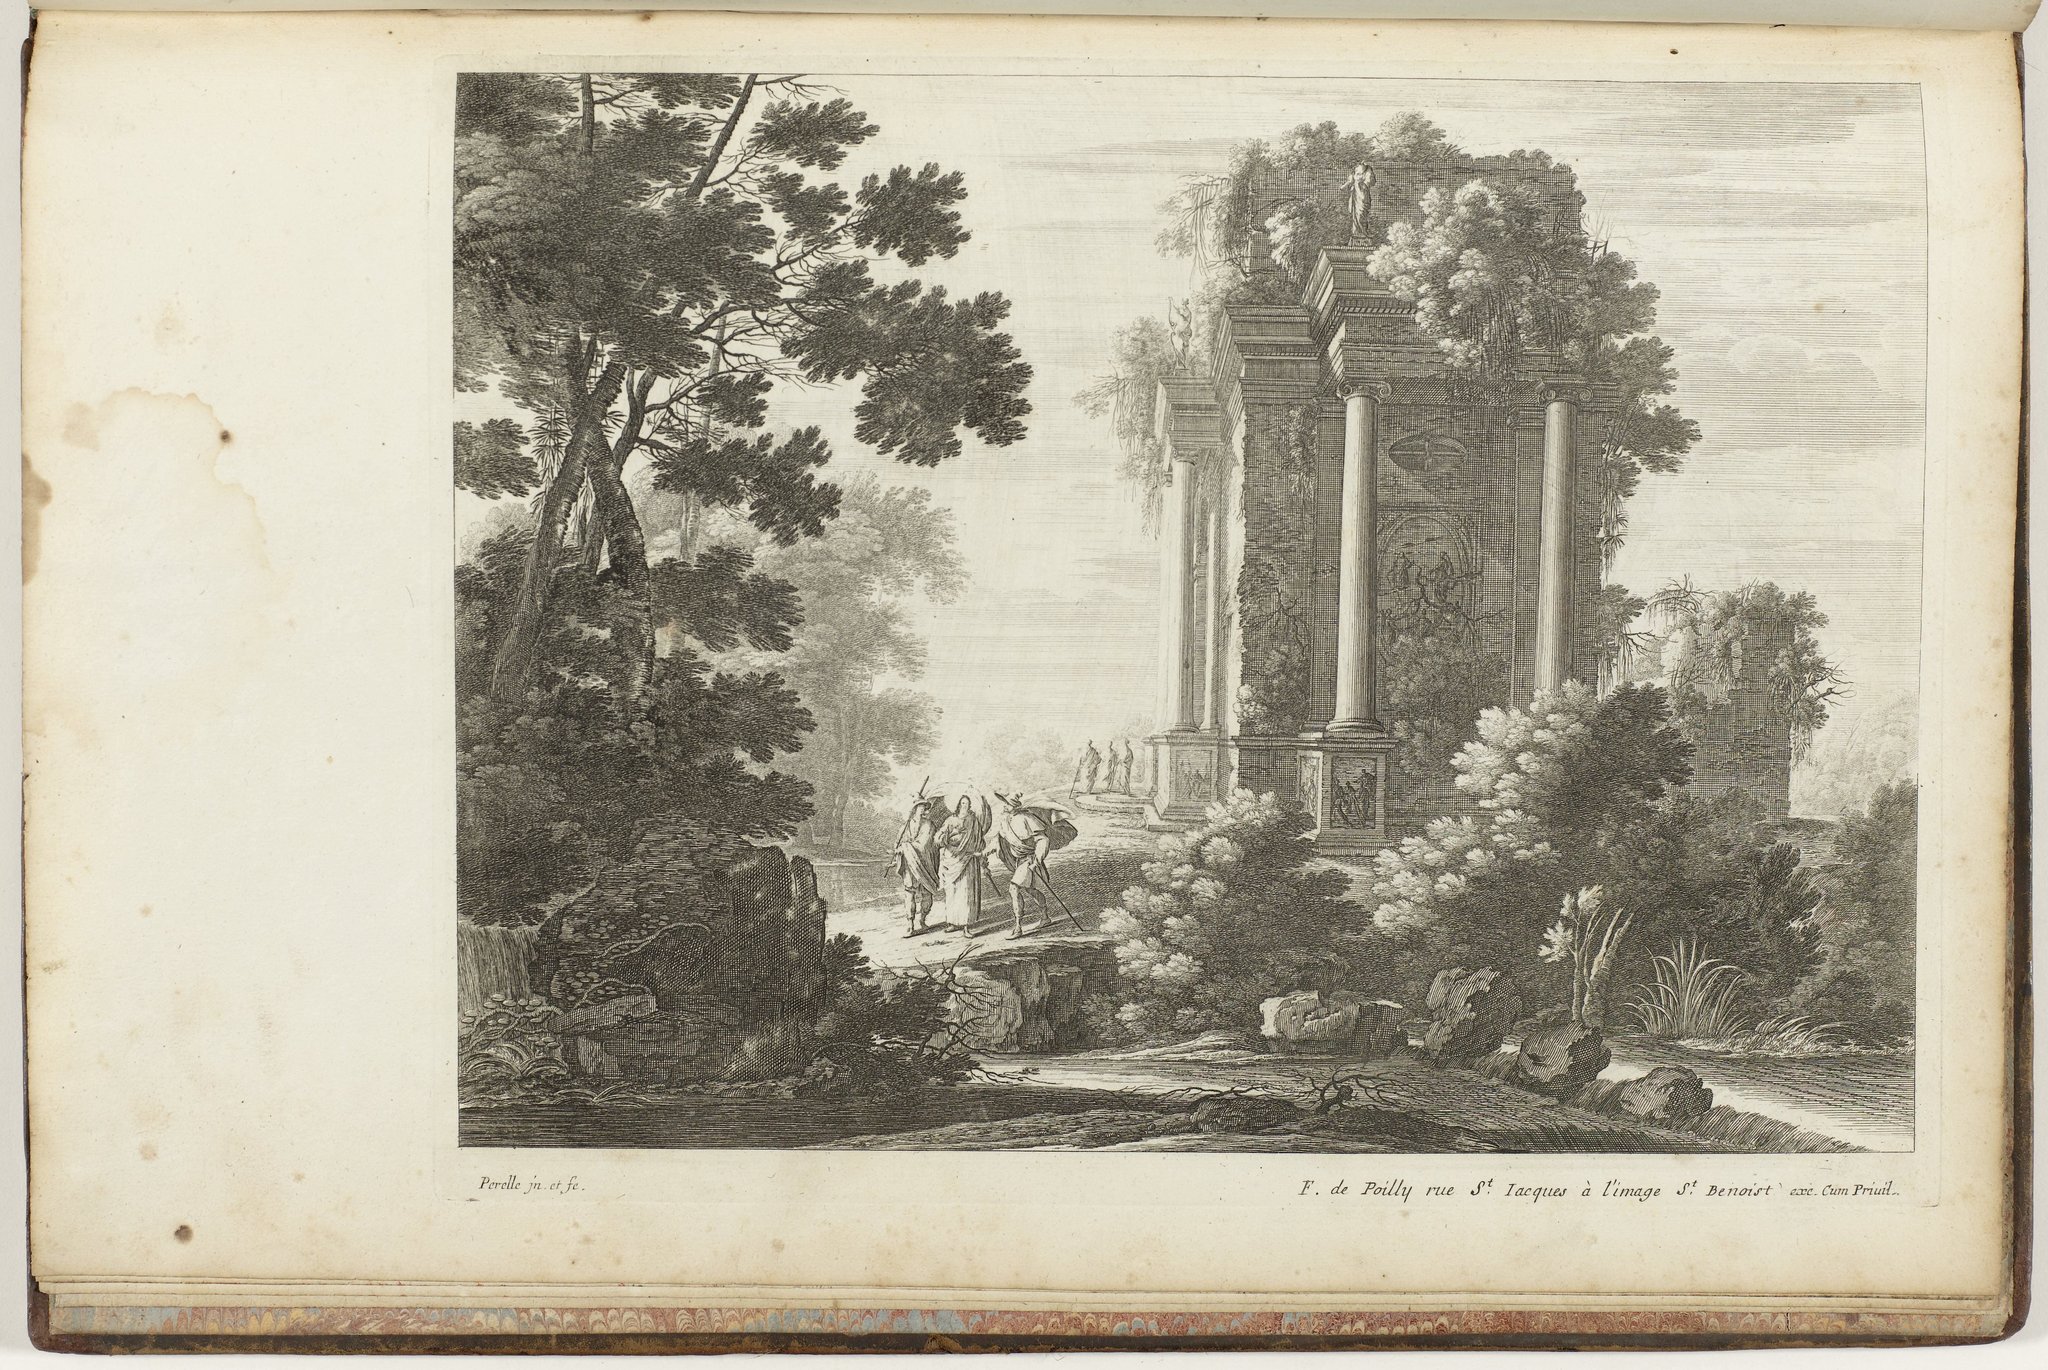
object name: print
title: Landschap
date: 1680-1695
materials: paper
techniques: etching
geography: paris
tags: landscape with ruins, cleopas and peter meet christ (sometimes they are dressed as pilgrims), landscapes in the temperate zone (+ landscape with figures, staffage)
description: Landschap. Ontwerp voor schildering boven schoorsteenmantel of deur? Prent maakt deel uit van een album.